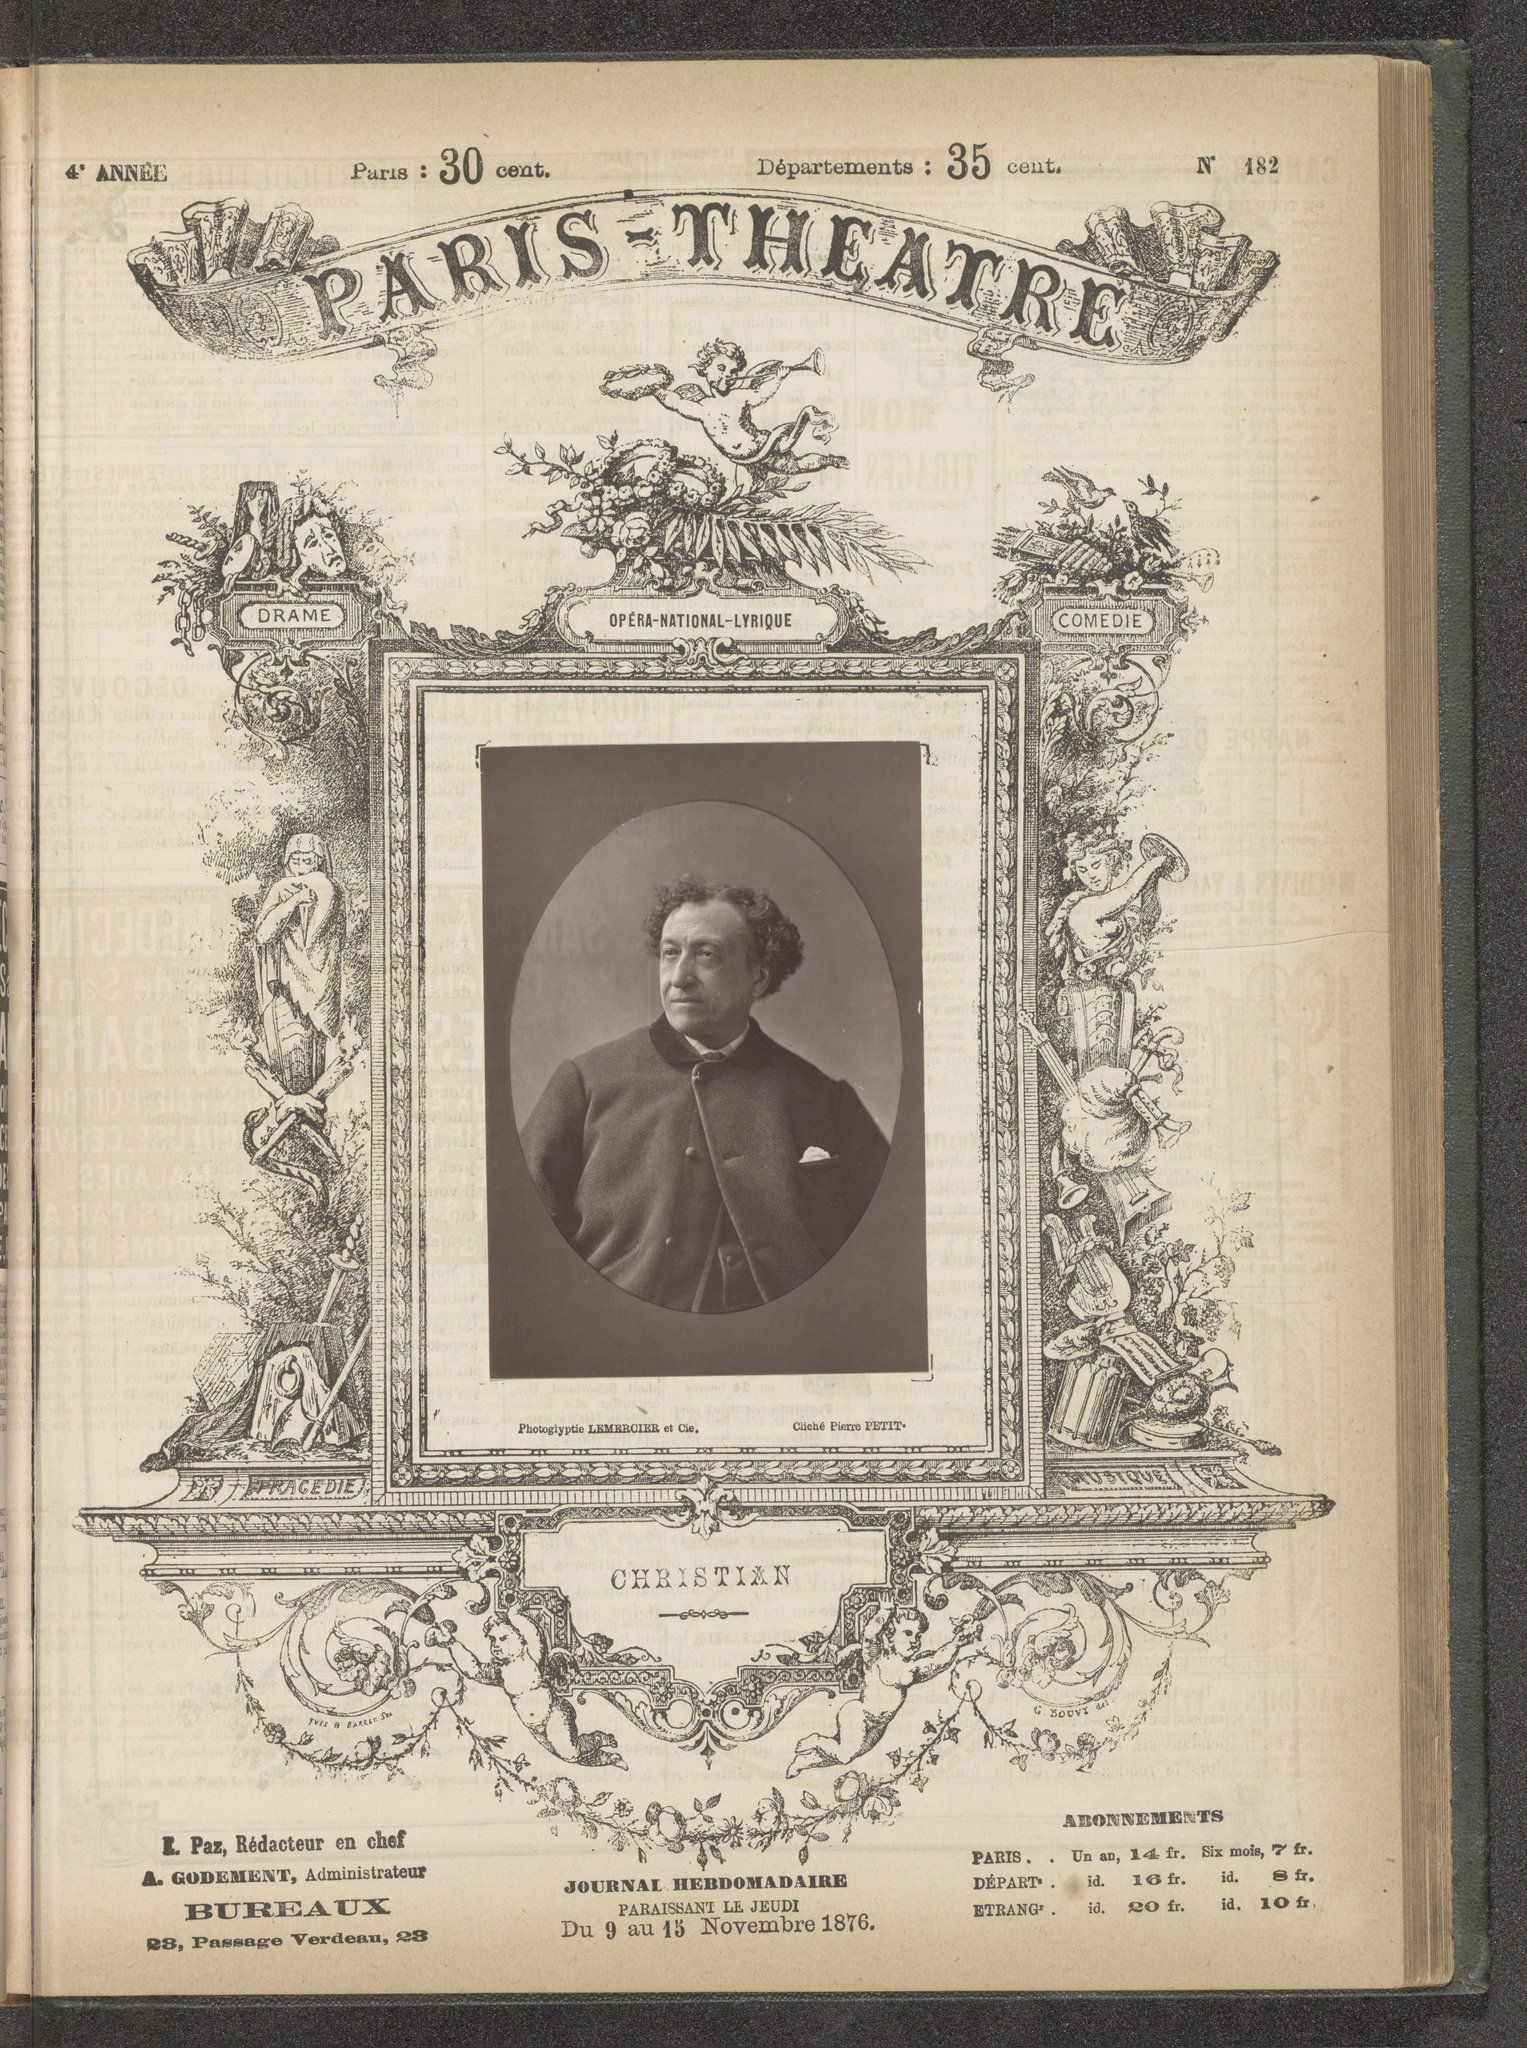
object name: photomechanical print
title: Christian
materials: paper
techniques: woodburytype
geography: france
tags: portrait of actor, actress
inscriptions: inscription: ‘Journal hebdomadaire paraissant le jeudi Du 9 au 15 Novembre 1876’, number: ‘N' 182’